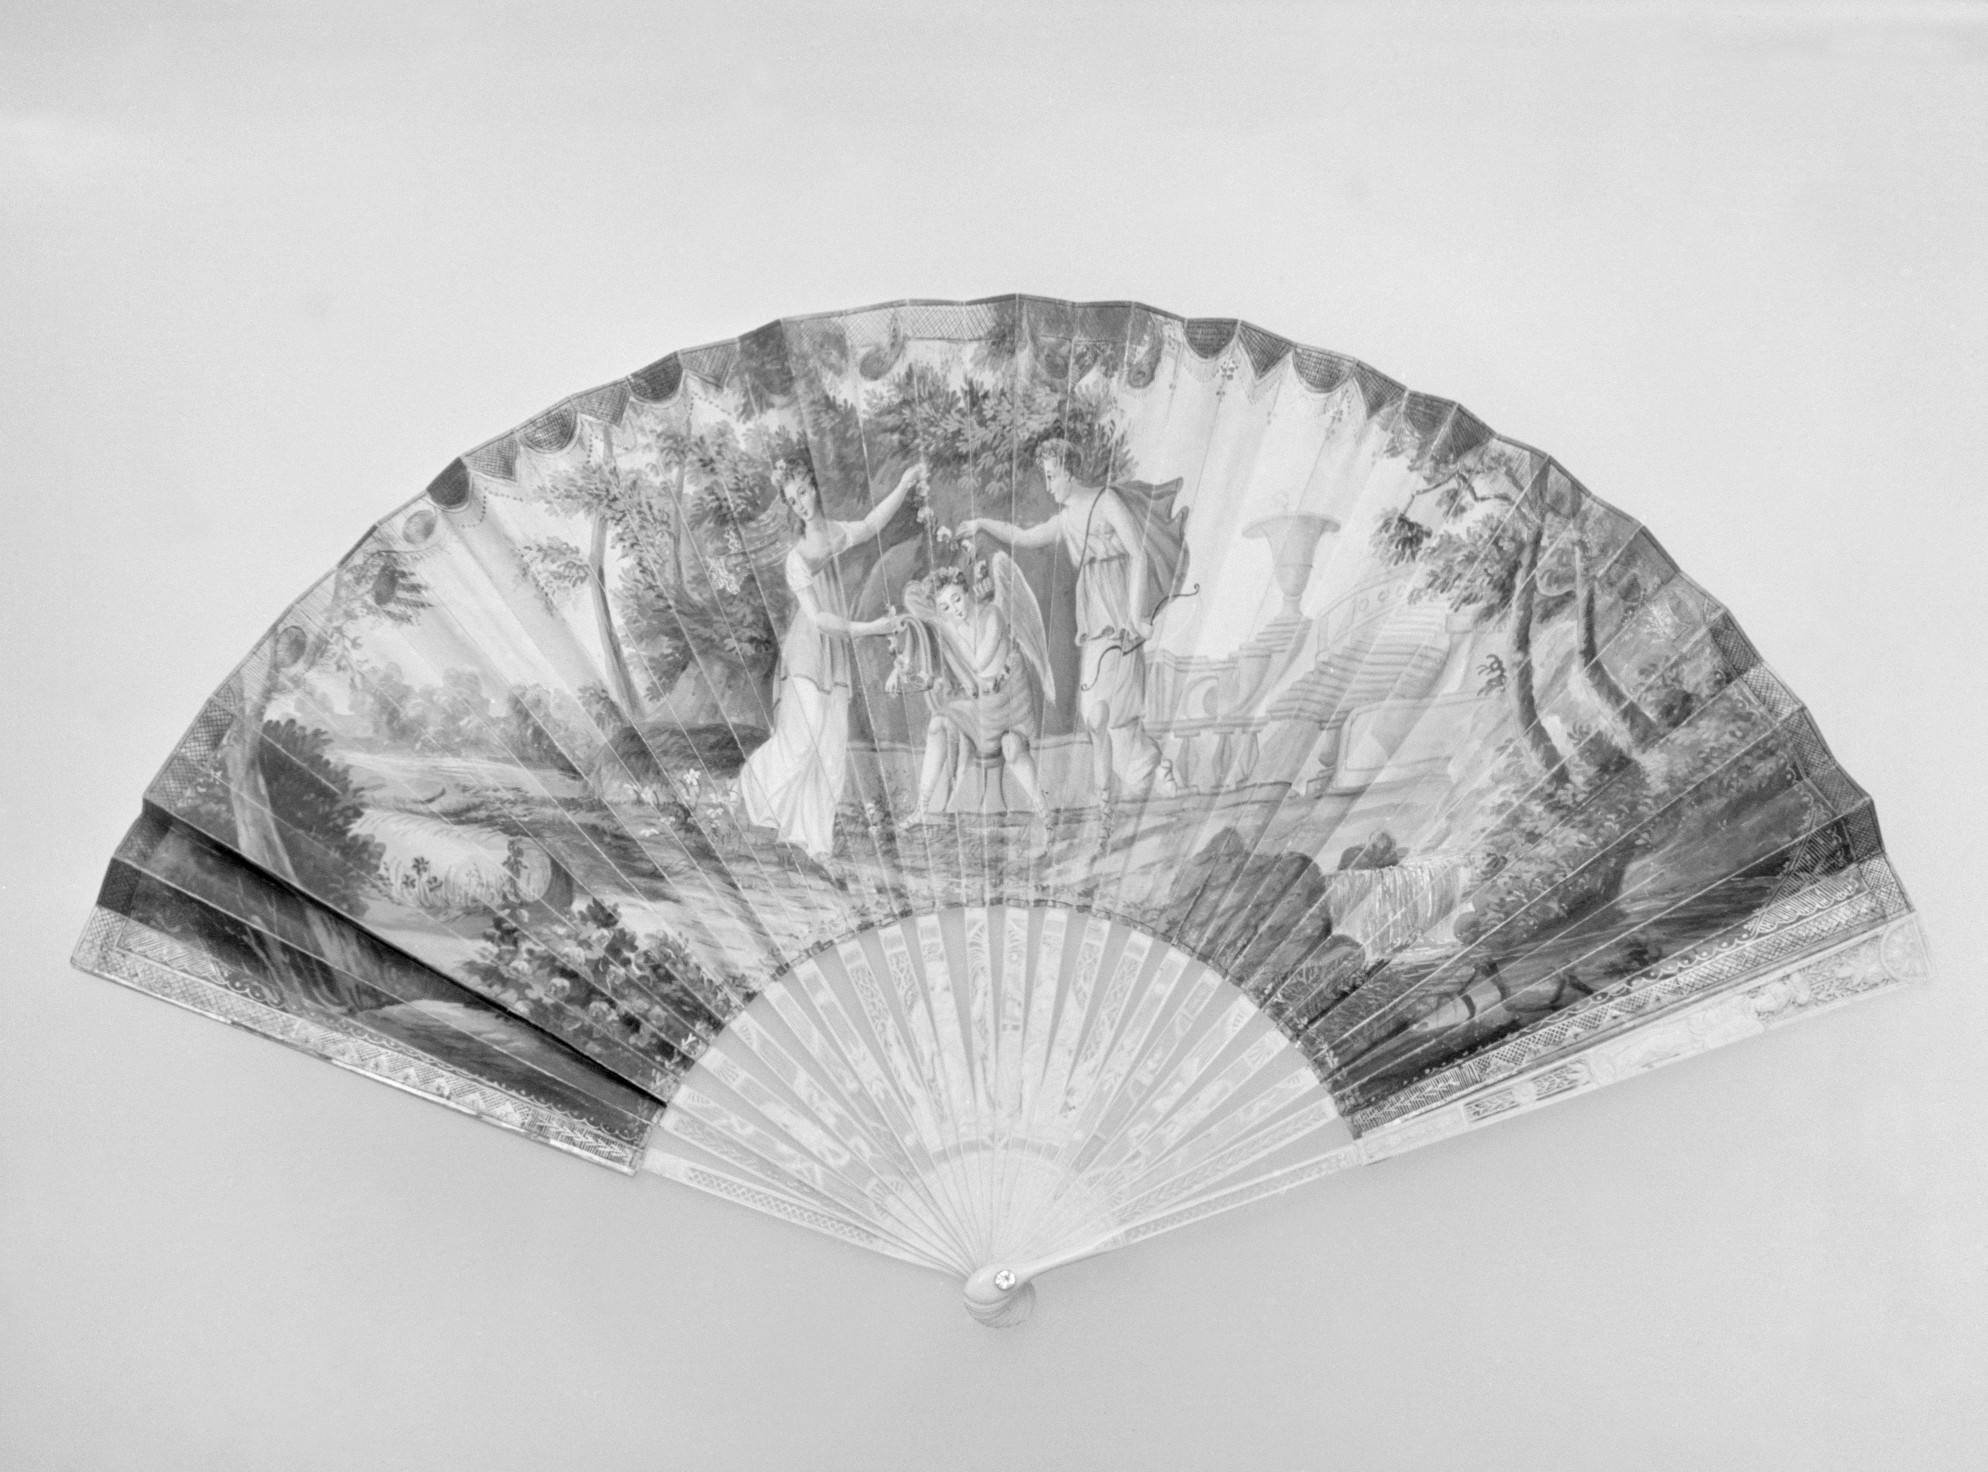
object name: fan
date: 1801-1833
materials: glass, ivory, parchment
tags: men,women